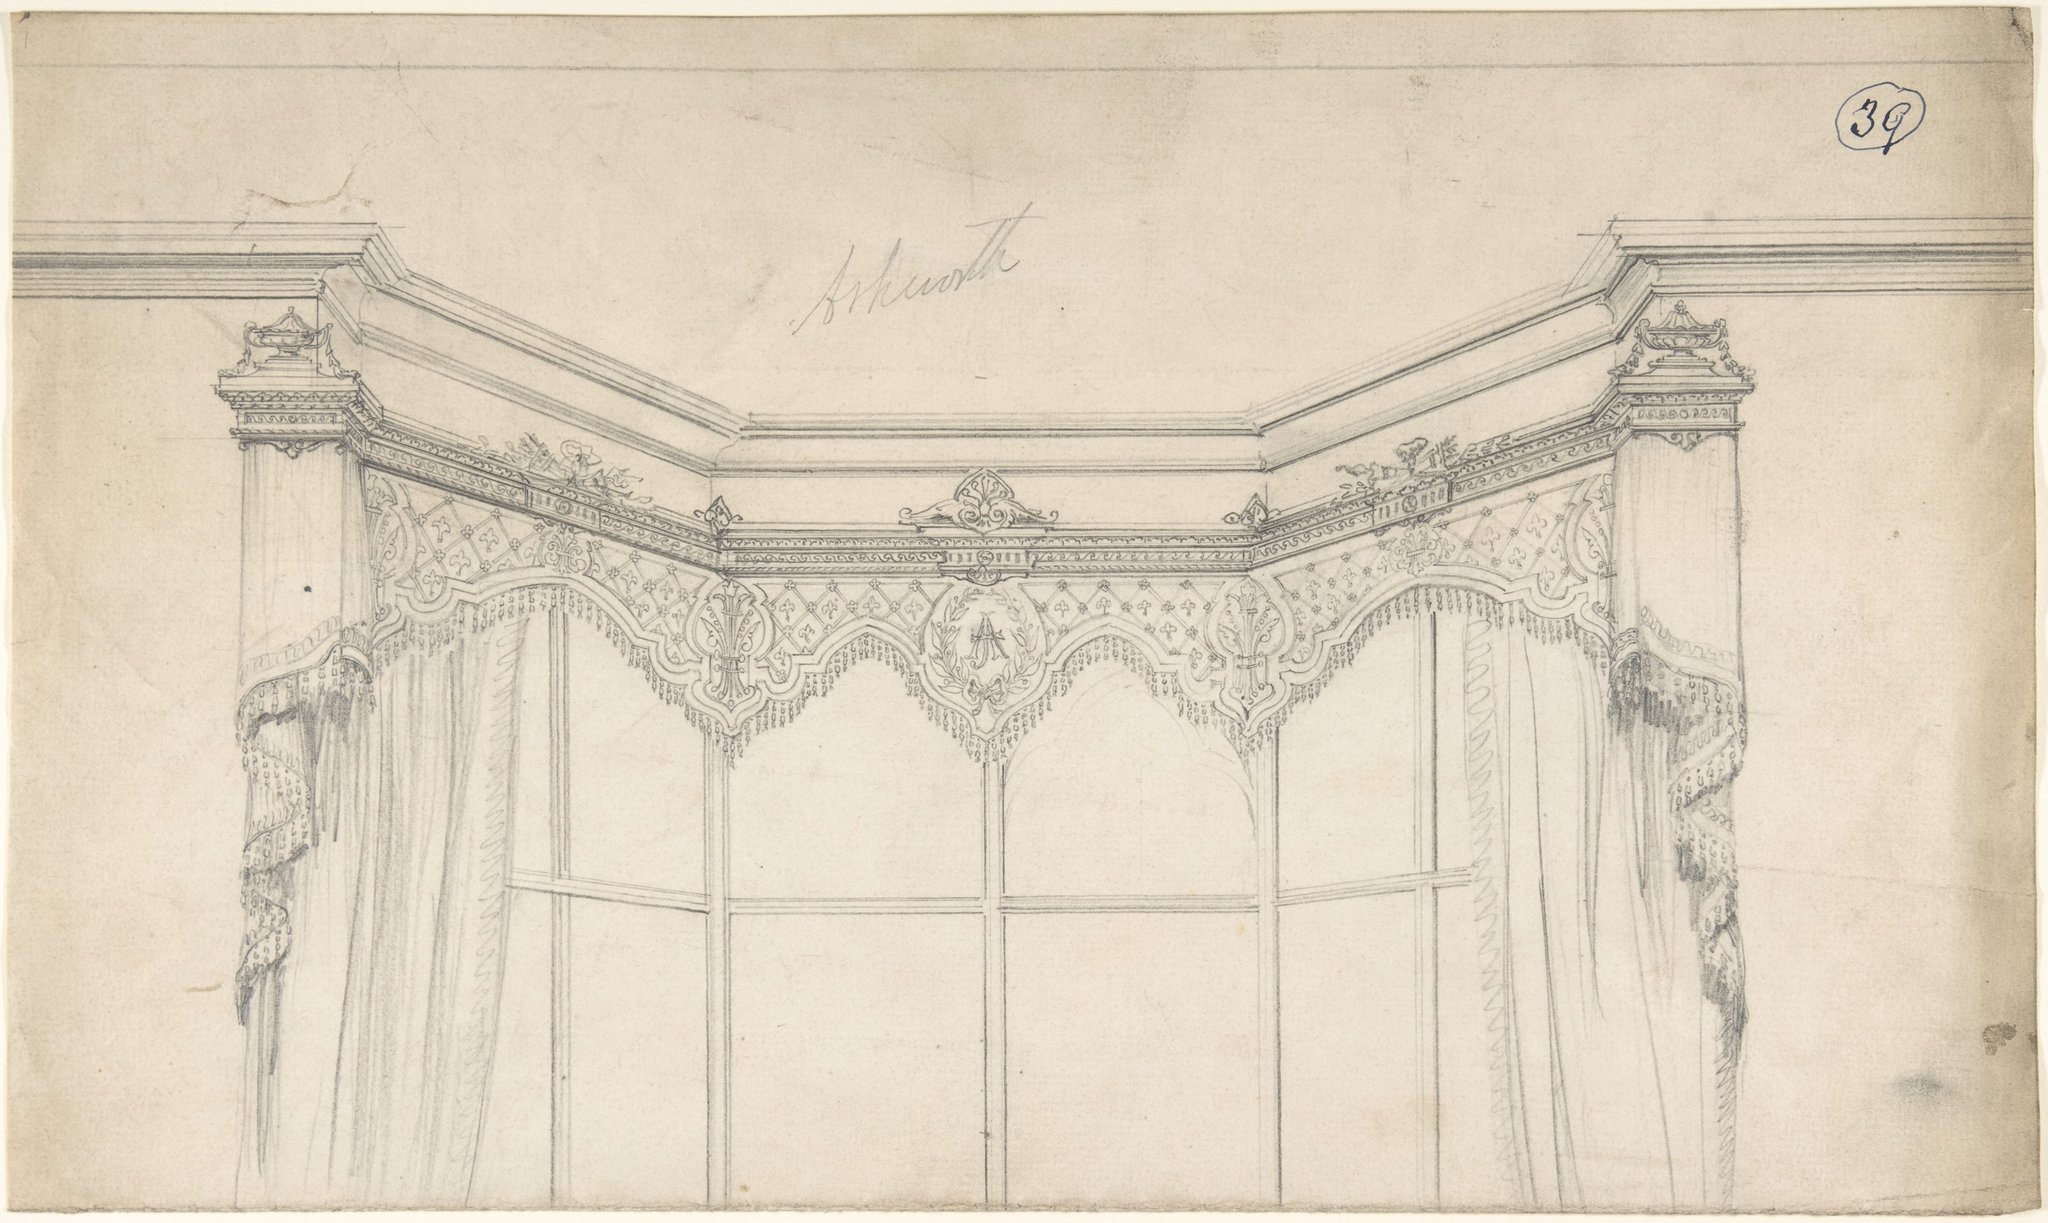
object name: drawing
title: Partial Design for Bay Window with Monogrammed Curtains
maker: charles hindley and sons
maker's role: artist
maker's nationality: british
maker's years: 1841-1917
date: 1841-1900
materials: graphite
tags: architecture,windows,curtains